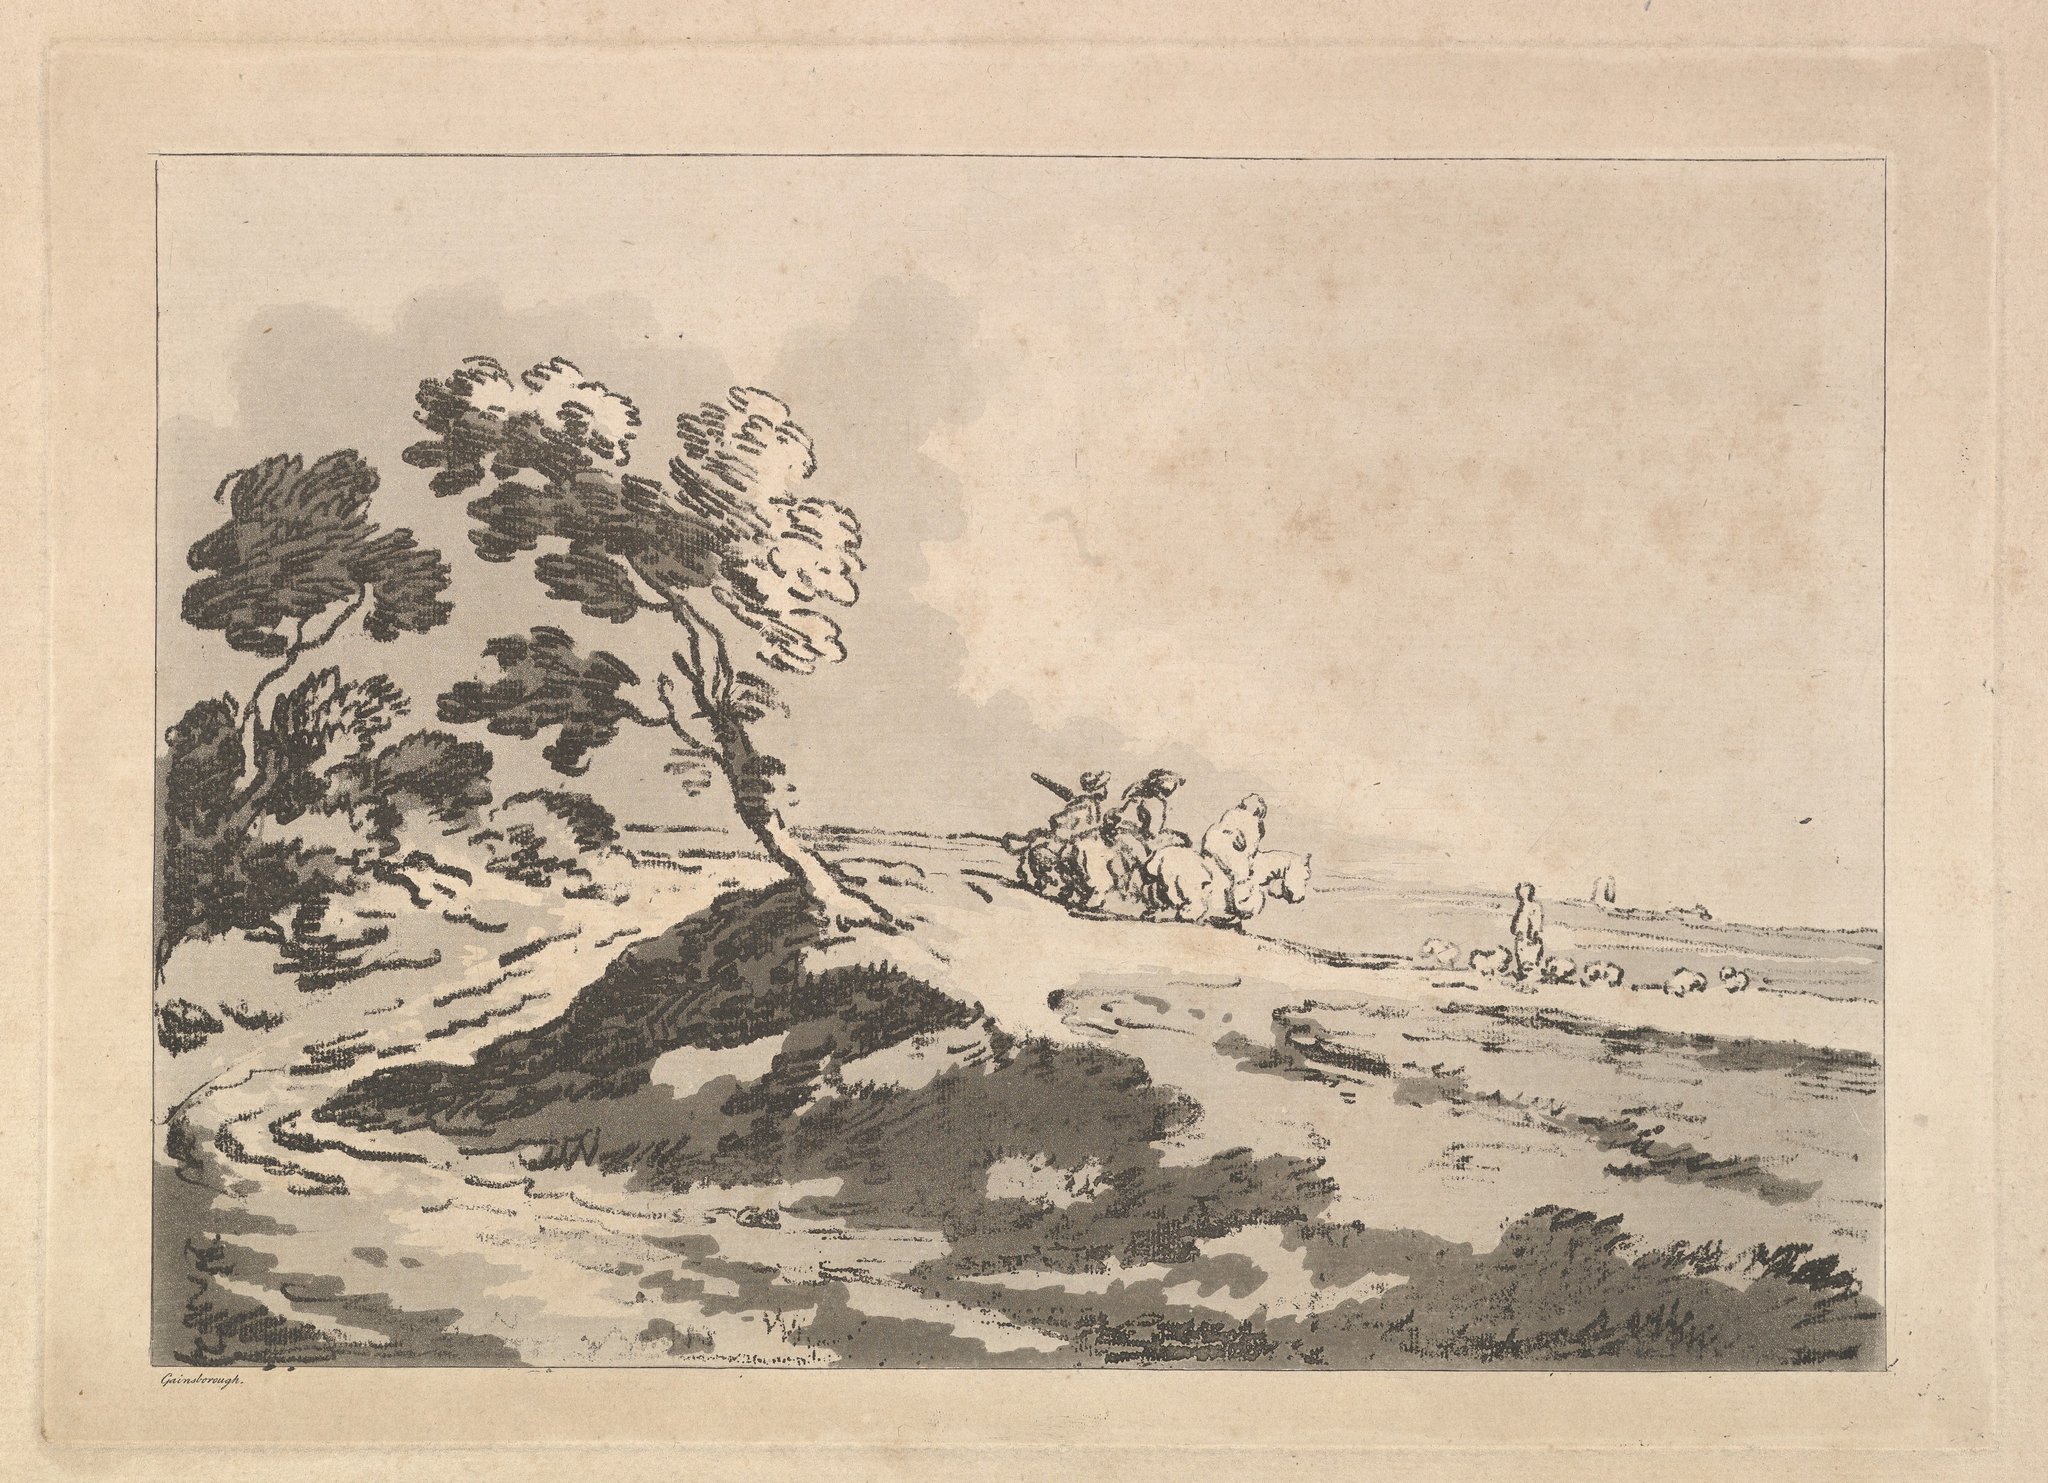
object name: print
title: Open Landscape with Three Horsemen in the Middle Distance Heading to the Right, Windblown Trees at Left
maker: thomas rowlandson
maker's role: artist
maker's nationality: british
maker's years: 1757-1827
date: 1784-1788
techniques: aquatint, etching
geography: england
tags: horses,landscapes,trees